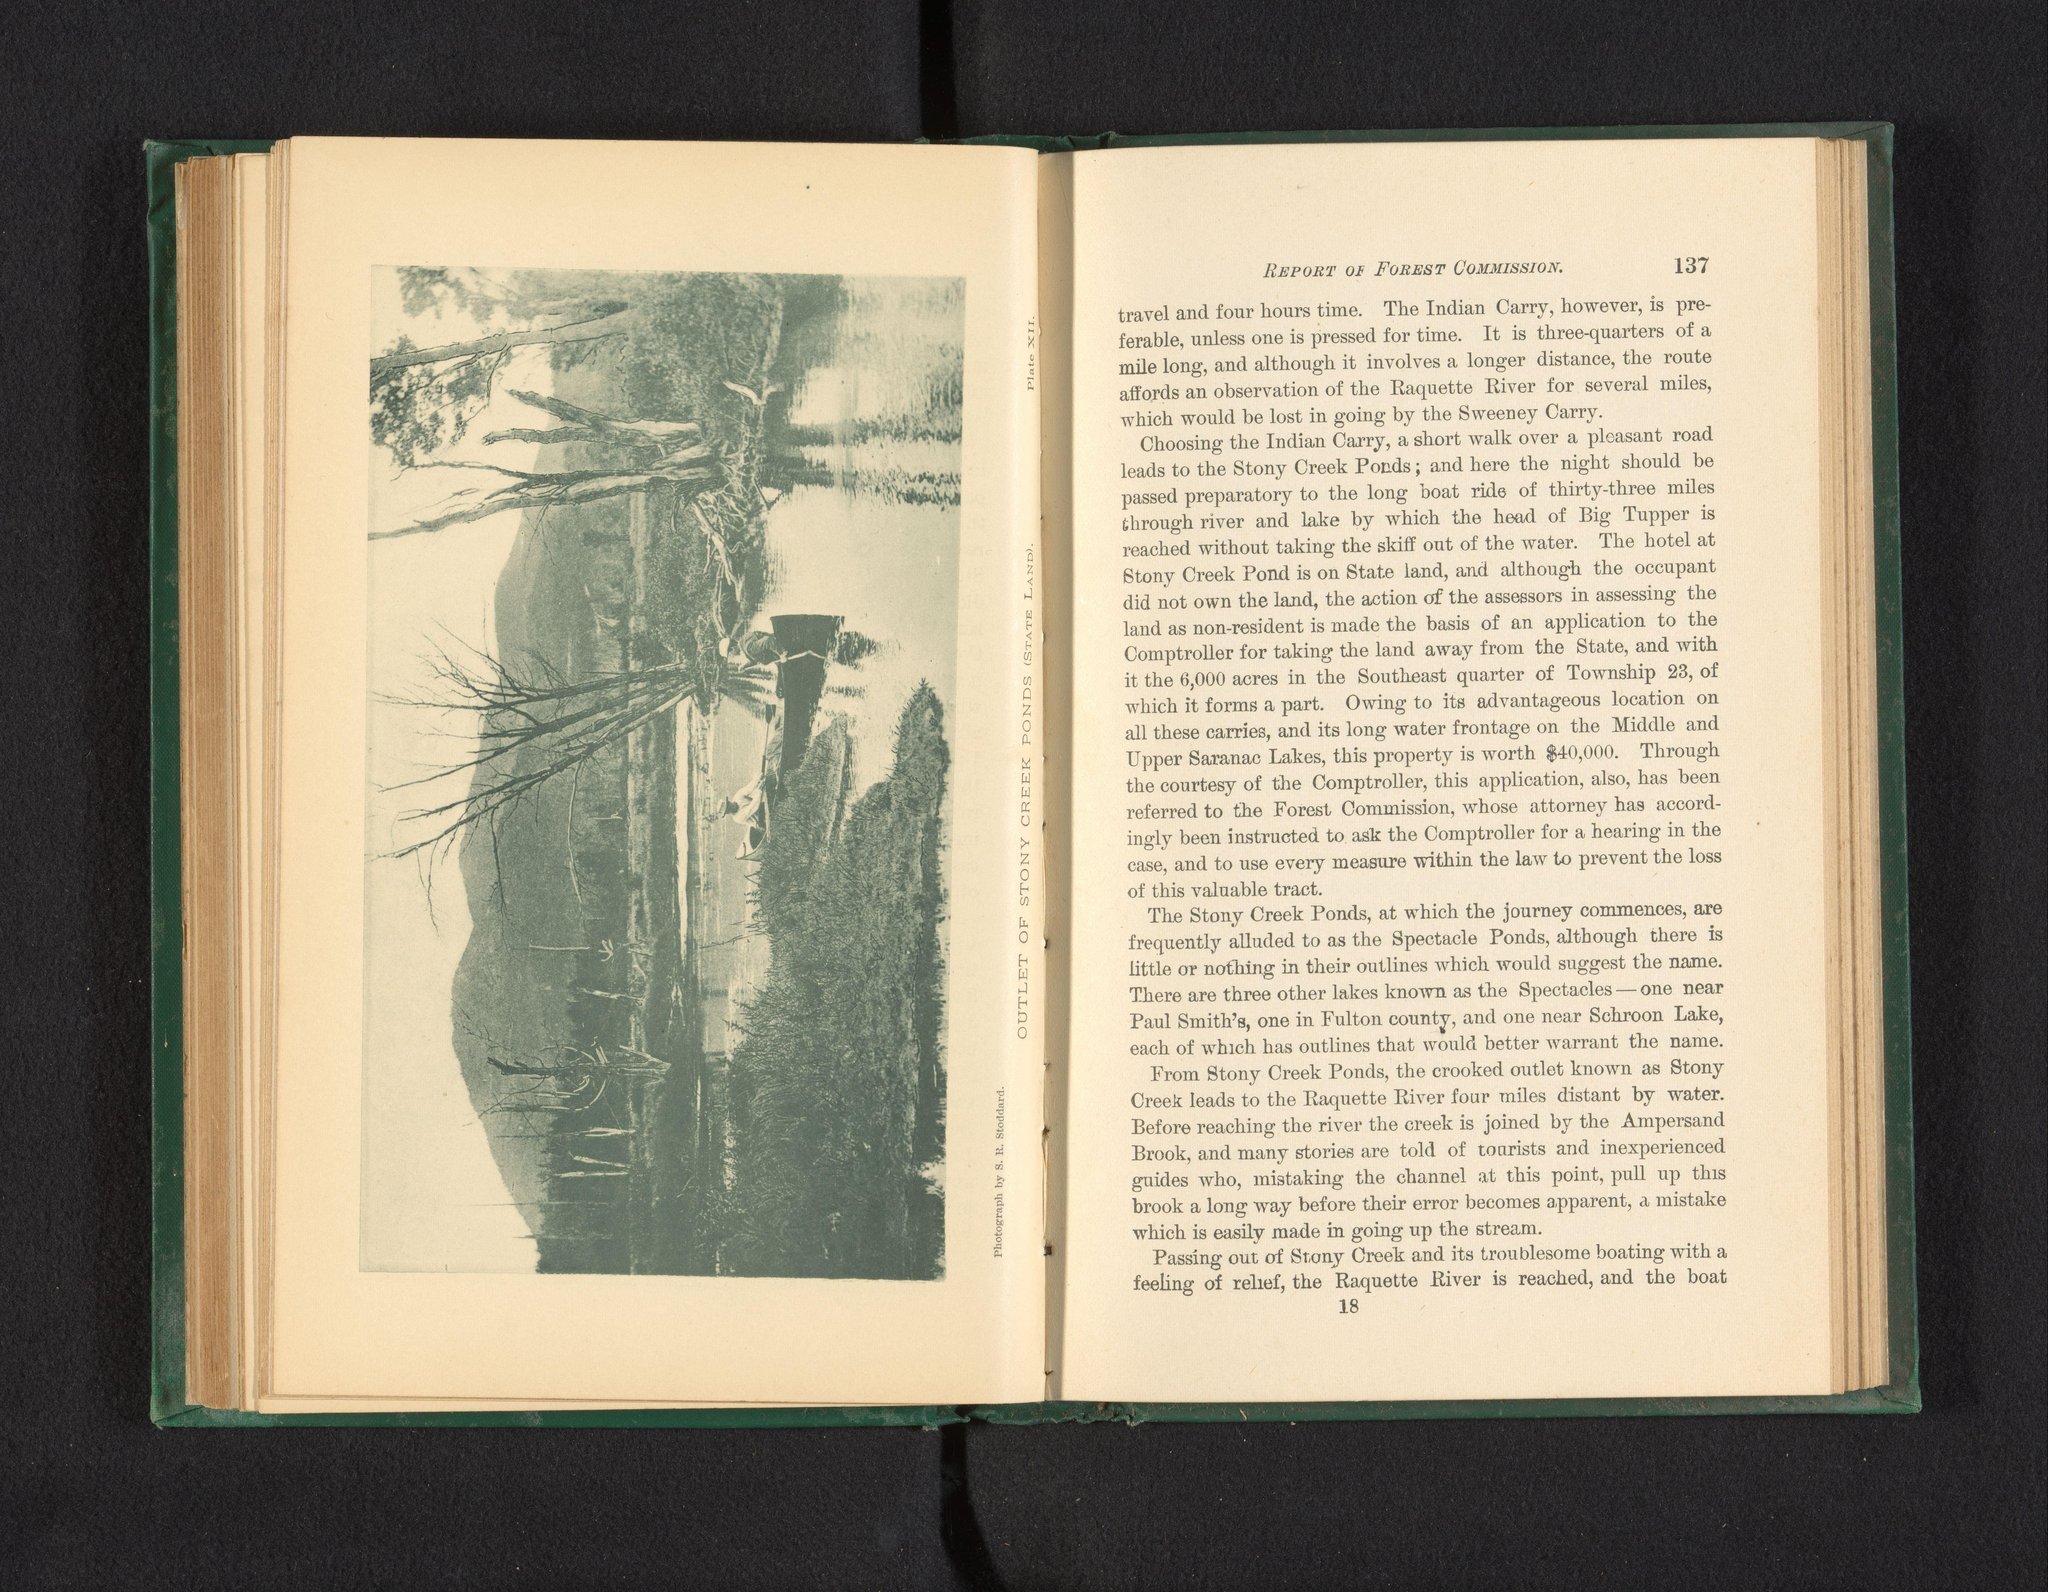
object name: page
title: Outlet of Stony Creek Ponds (State land)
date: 1891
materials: paper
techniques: photograph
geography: new york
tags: rowing-boat, canoe, etc., pond, pool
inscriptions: number: ‘Plate XII.’